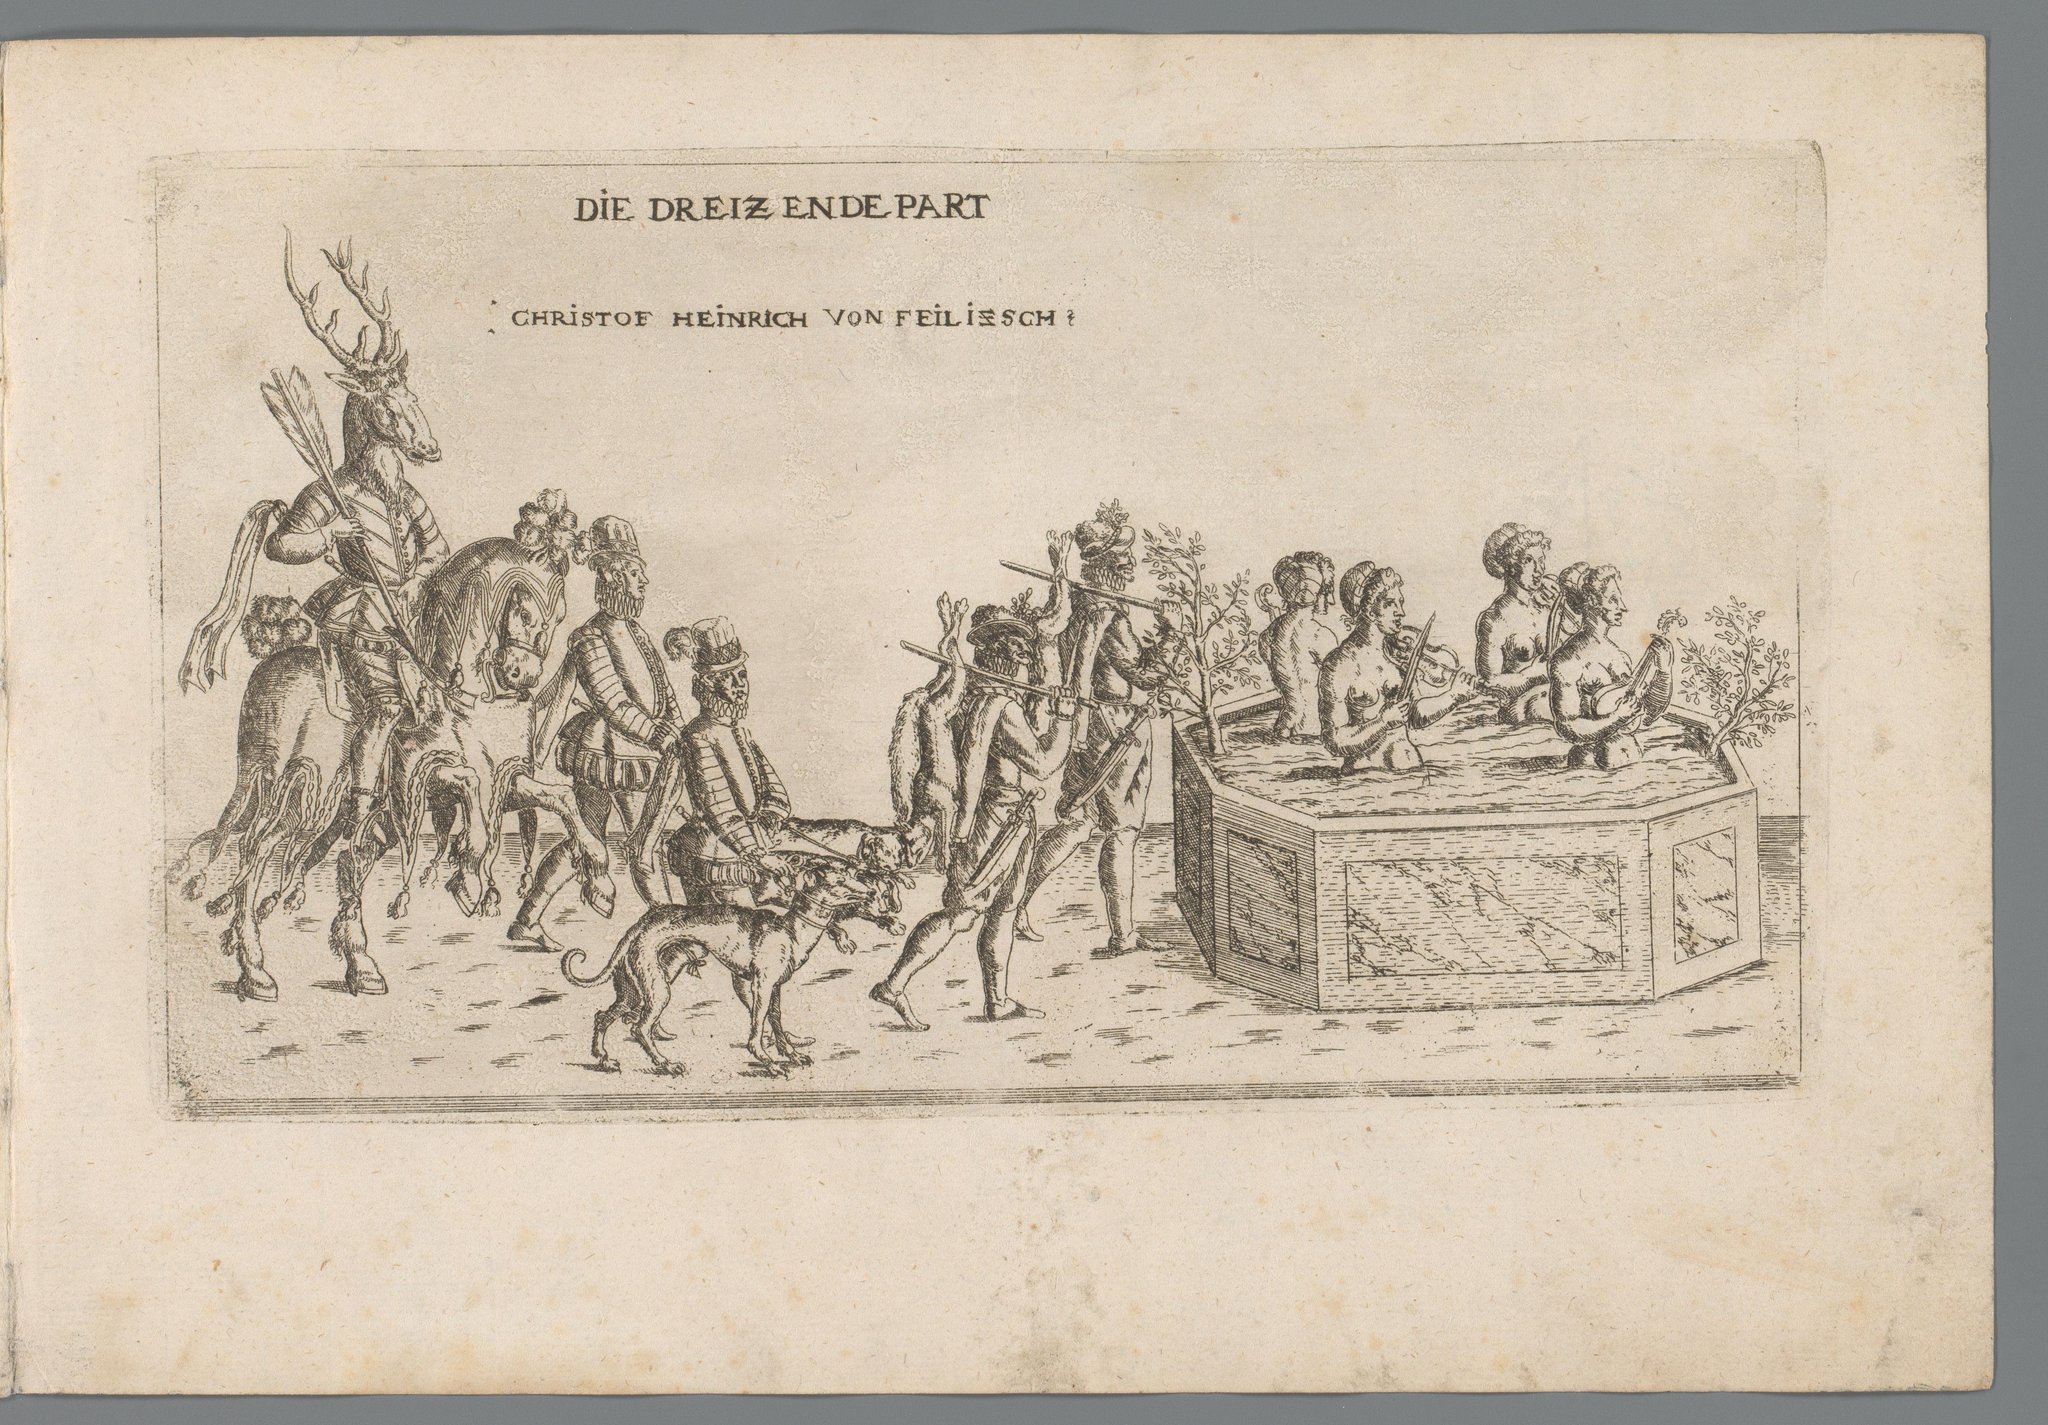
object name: print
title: Die dreizende Part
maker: Anonymous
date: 1553-1586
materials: paper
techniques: etching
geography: germany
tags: riding a horse, ass, or mule; rider, horseman, dress-up party, rejoicing on special occasions (+ parade, pageant, cavalcade ~ festive activities), taking a bath - aa - in the open air, the (nude) human figure; 'corpo humano' (ripa) - aa - female human figure, return from the hunt, small group of musicians, chamber orchestra, jazz band - cc - 'concert champêtre'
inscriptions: collector's mark: Lugt 2760, collector's mark: Lugt 2228